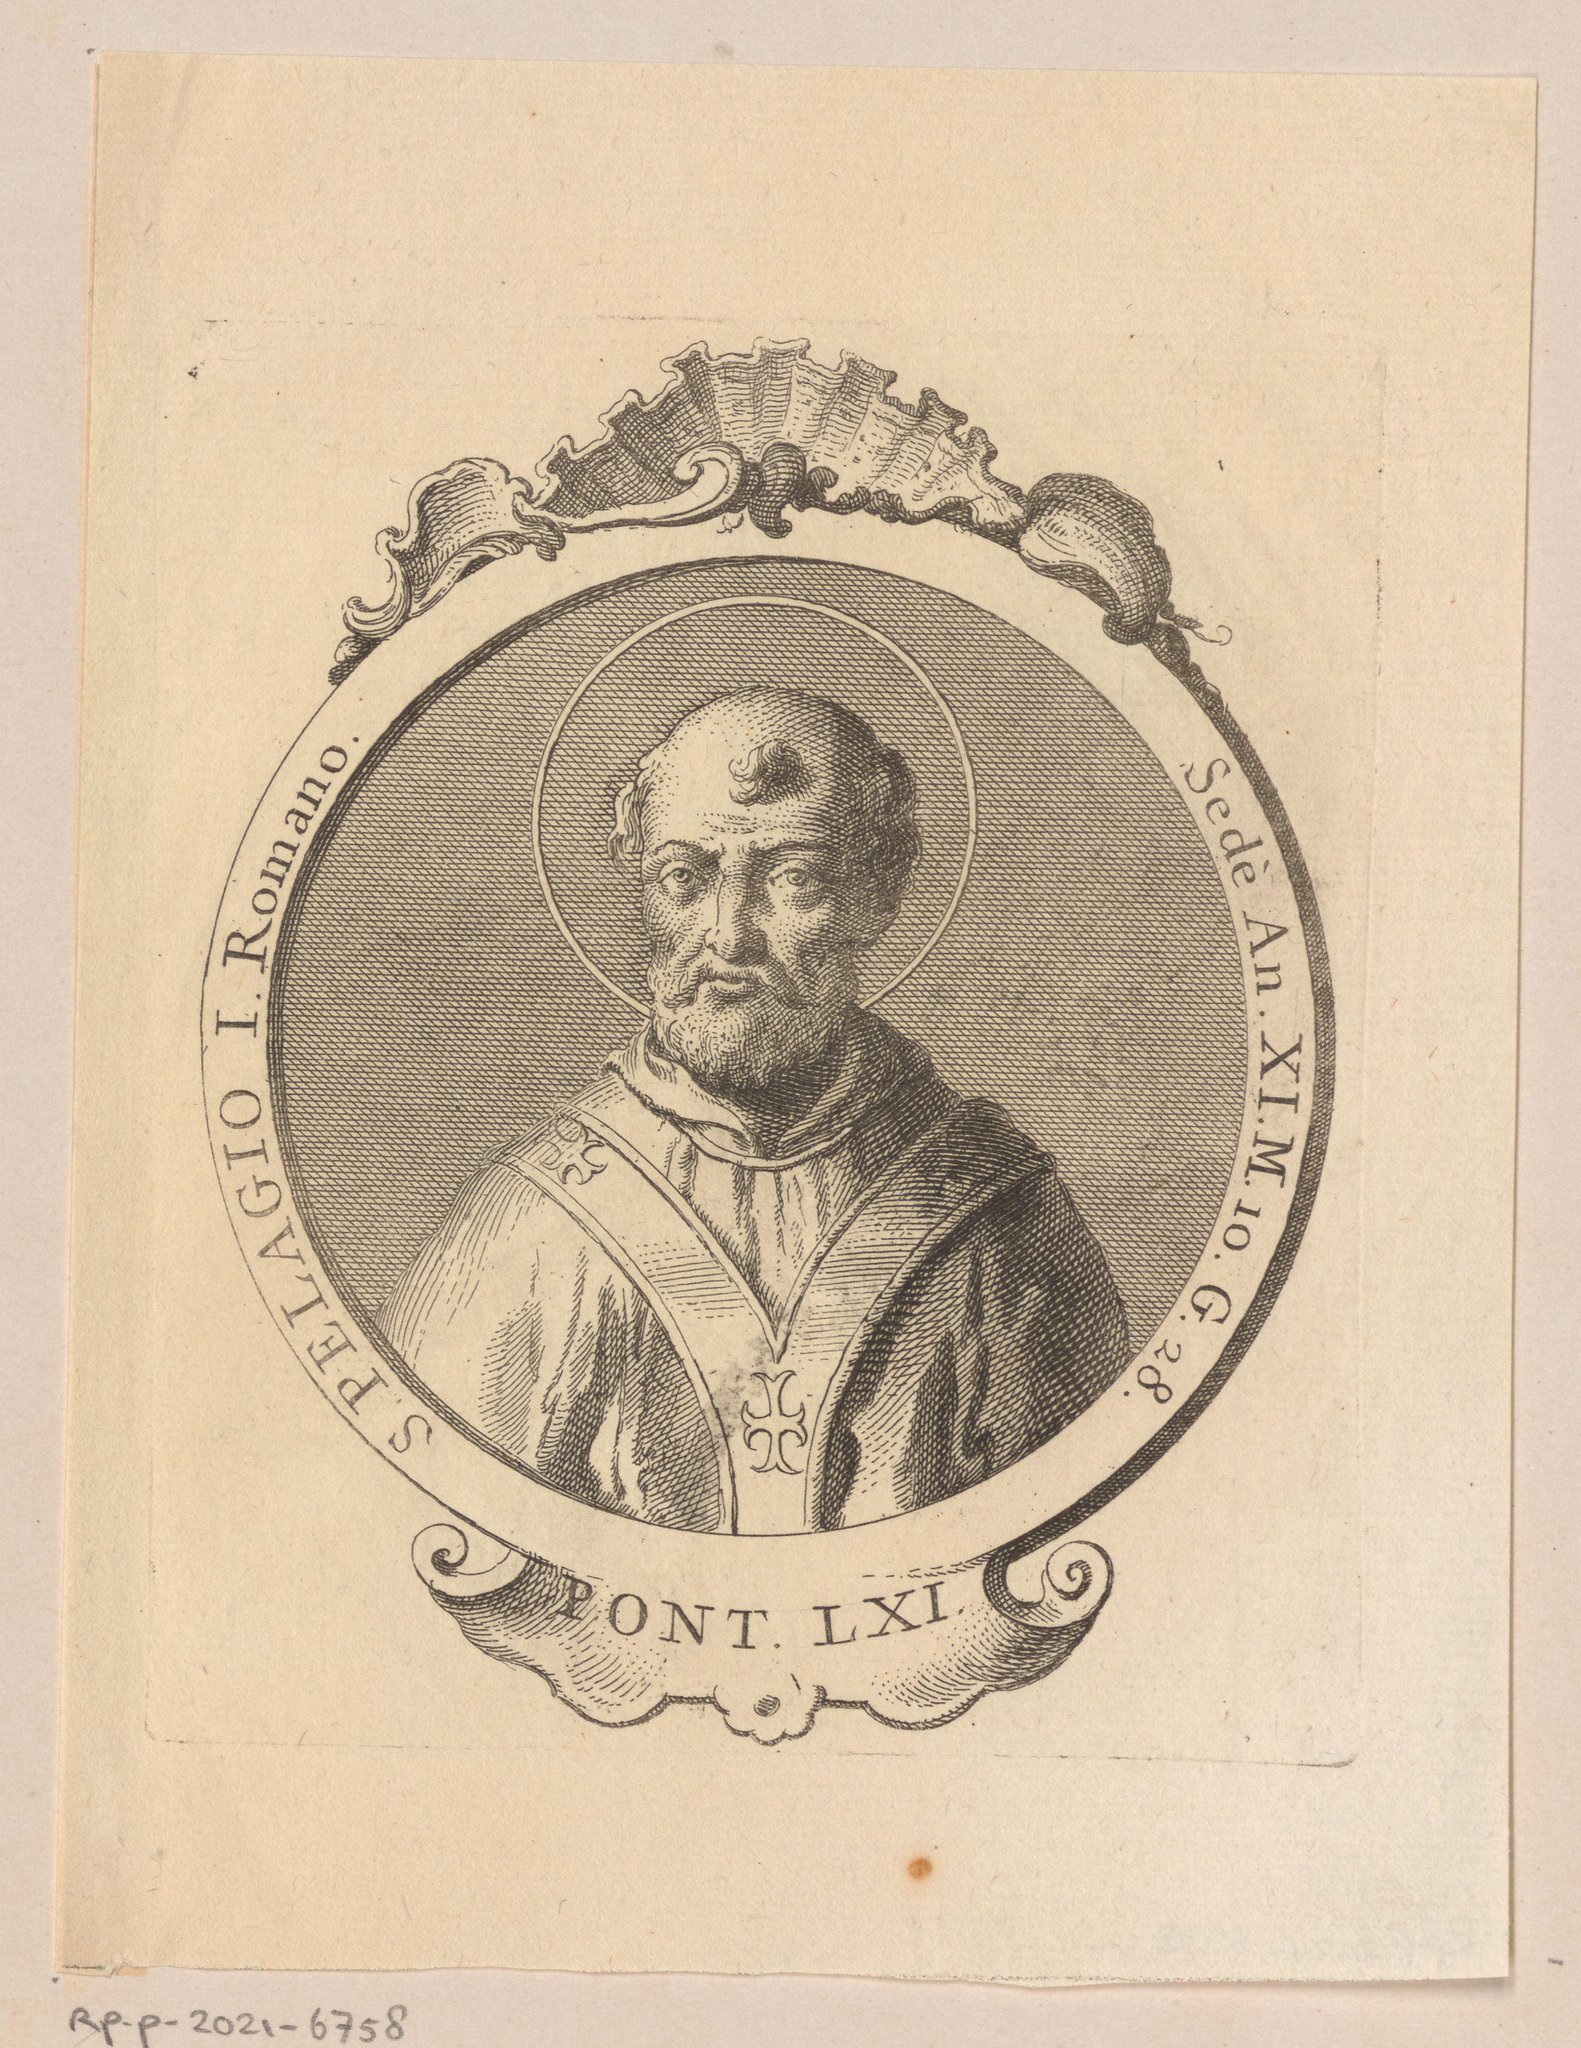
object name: print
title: Portret van paus Pelagius I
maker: Anonymous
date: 1775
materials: paper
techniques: engraving, etching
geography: italy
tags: adult man, historical persons, pope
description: Prent waarschijnlijk uit: Effigies Romanorum pontificum a S. Petro ad Pium VI (...). 2 dln. Venetië en Bassano del Grappa: Giuseppe Remondini, 1775, dl 1. Prent met tekst in boekdruk op verso gebruikt in: Platina (Bartholomaeus Sacchi). Storia delle vite dei pontefici da Platina e d'altri autori (...). 5 dln. Venetië: Domenico Ferrarin, 1760, dl. 1.